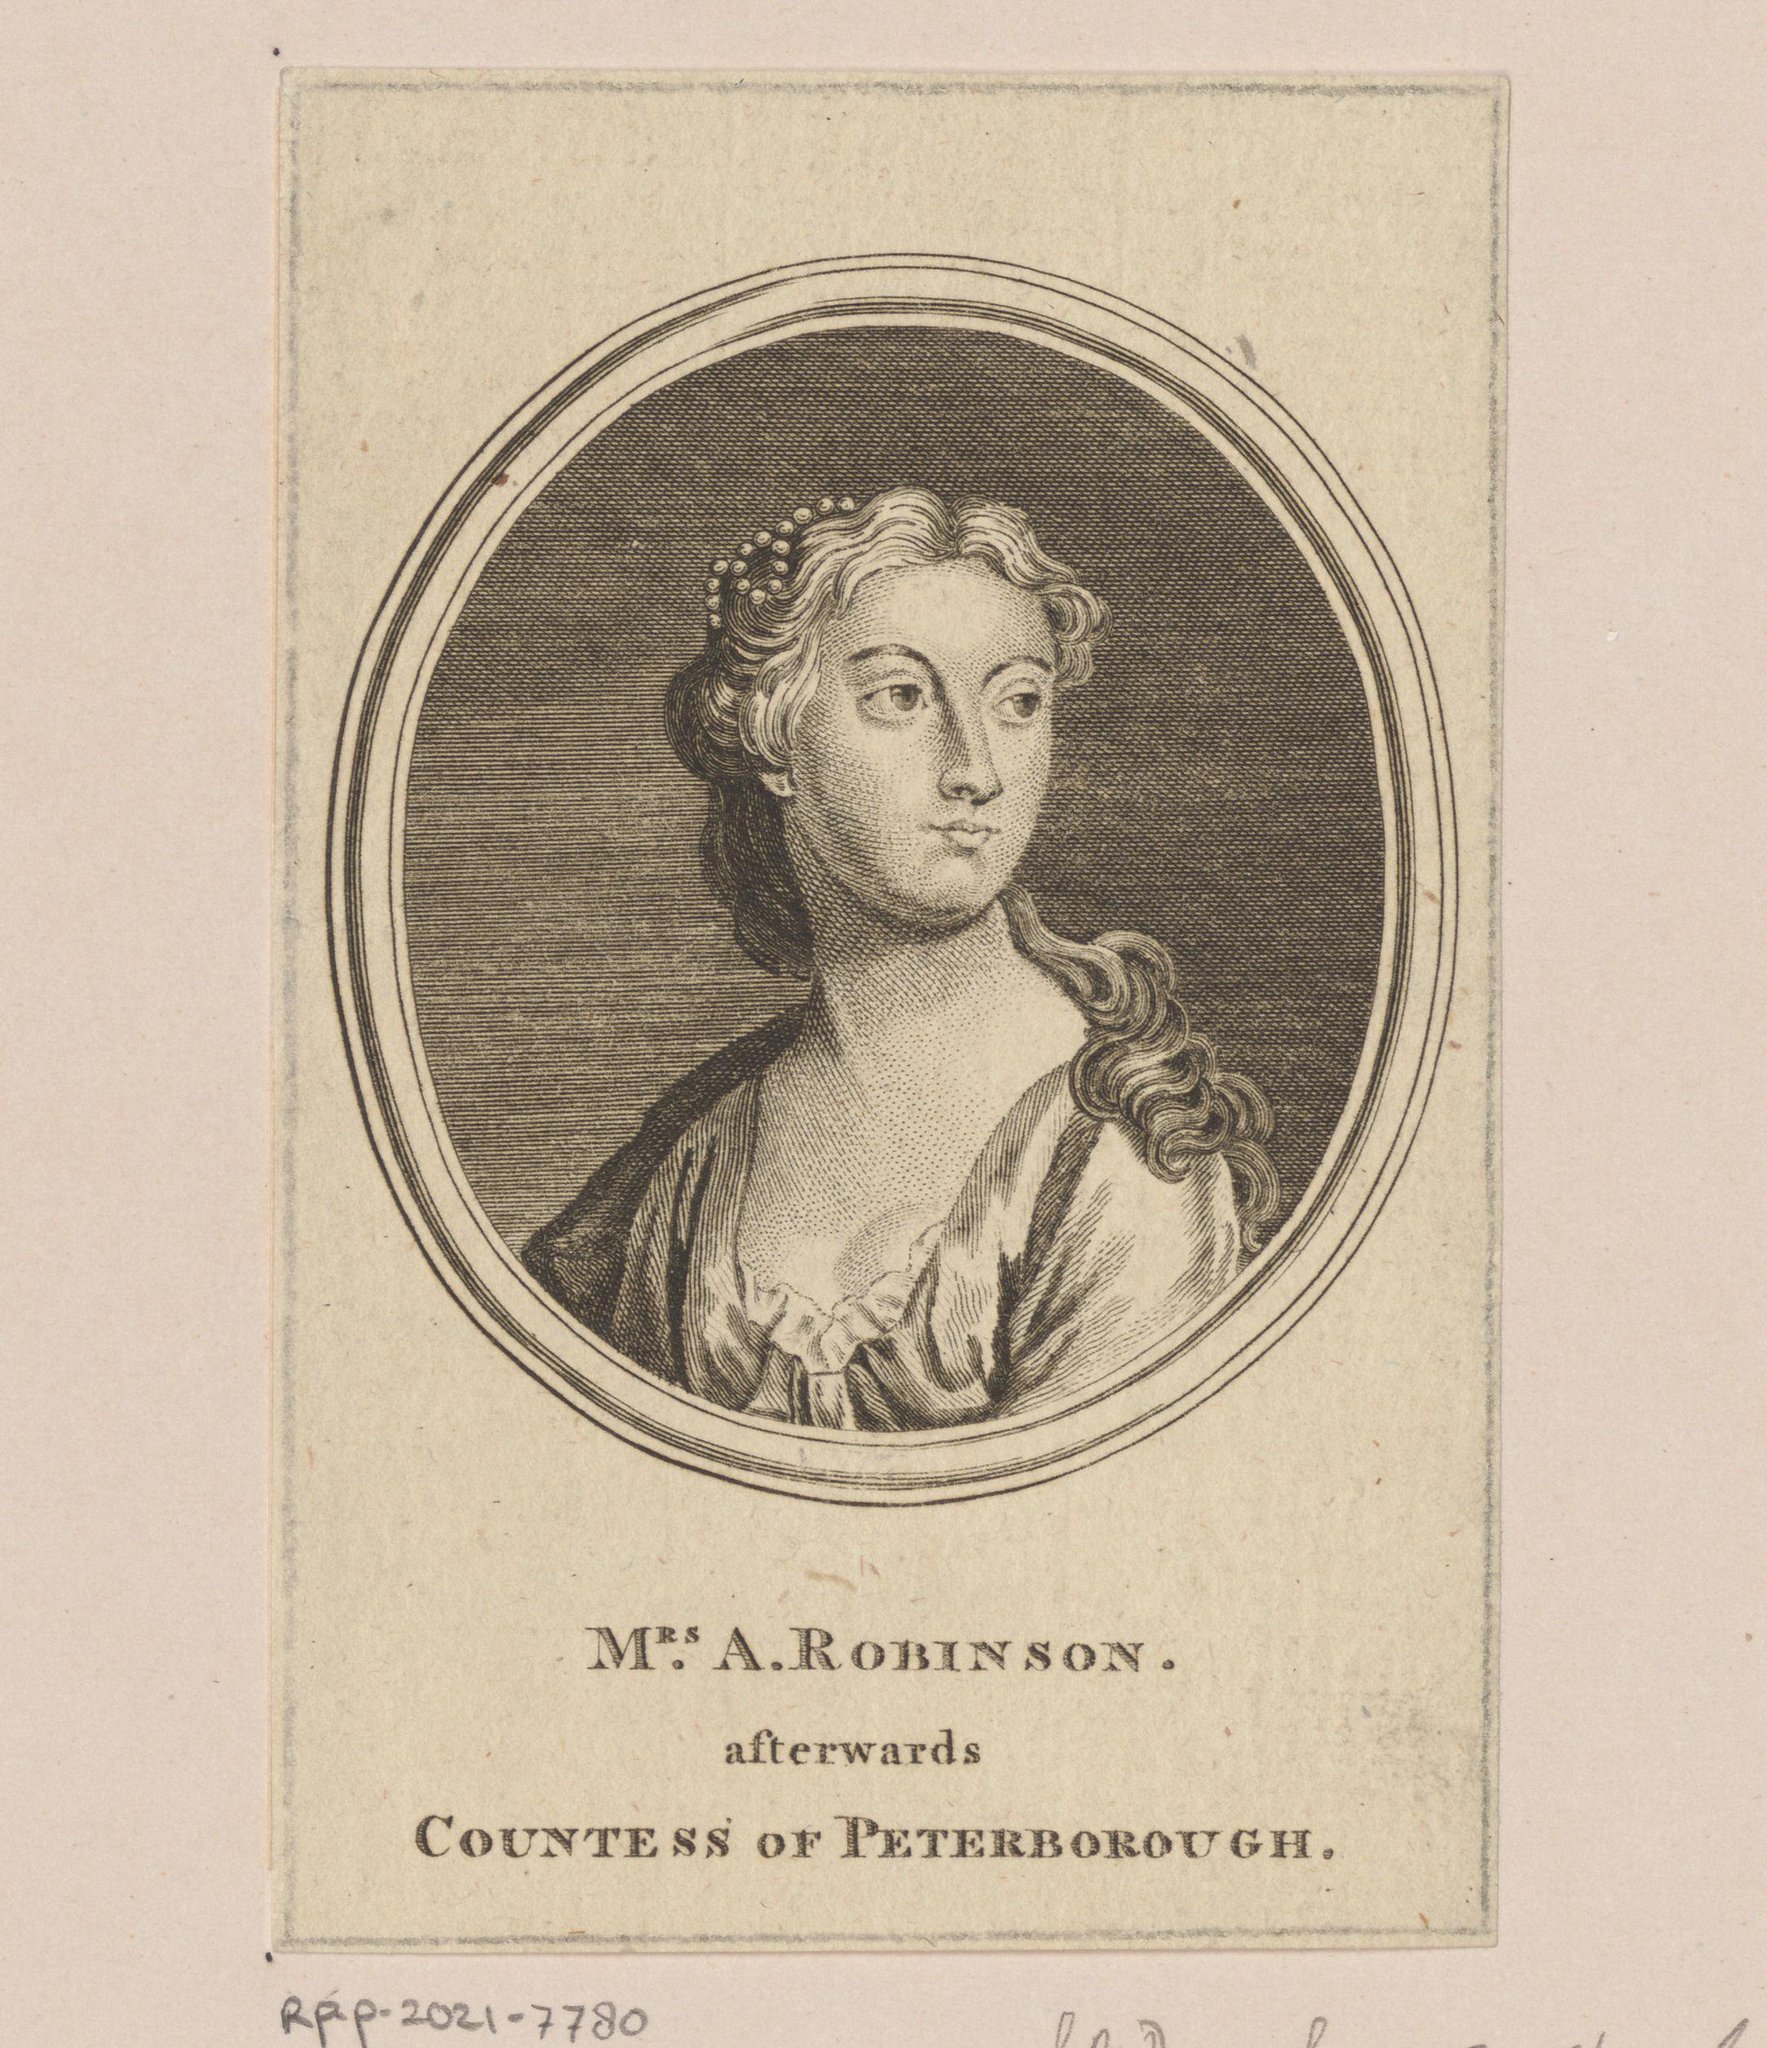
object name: print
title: Portret van Anastasia Robinson, gravin van Peterborough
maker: thornton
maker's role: print maker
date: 1790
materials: paper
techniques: engraving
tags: adult woman, historical persons, opera-singer (female)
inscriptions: inscription: ‘Concert-zangeres-later/ (...) 1974/ 1777’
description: Prent waarschijnlijk uit: The New Lady's Magazine 5 (1790), juni 1790.